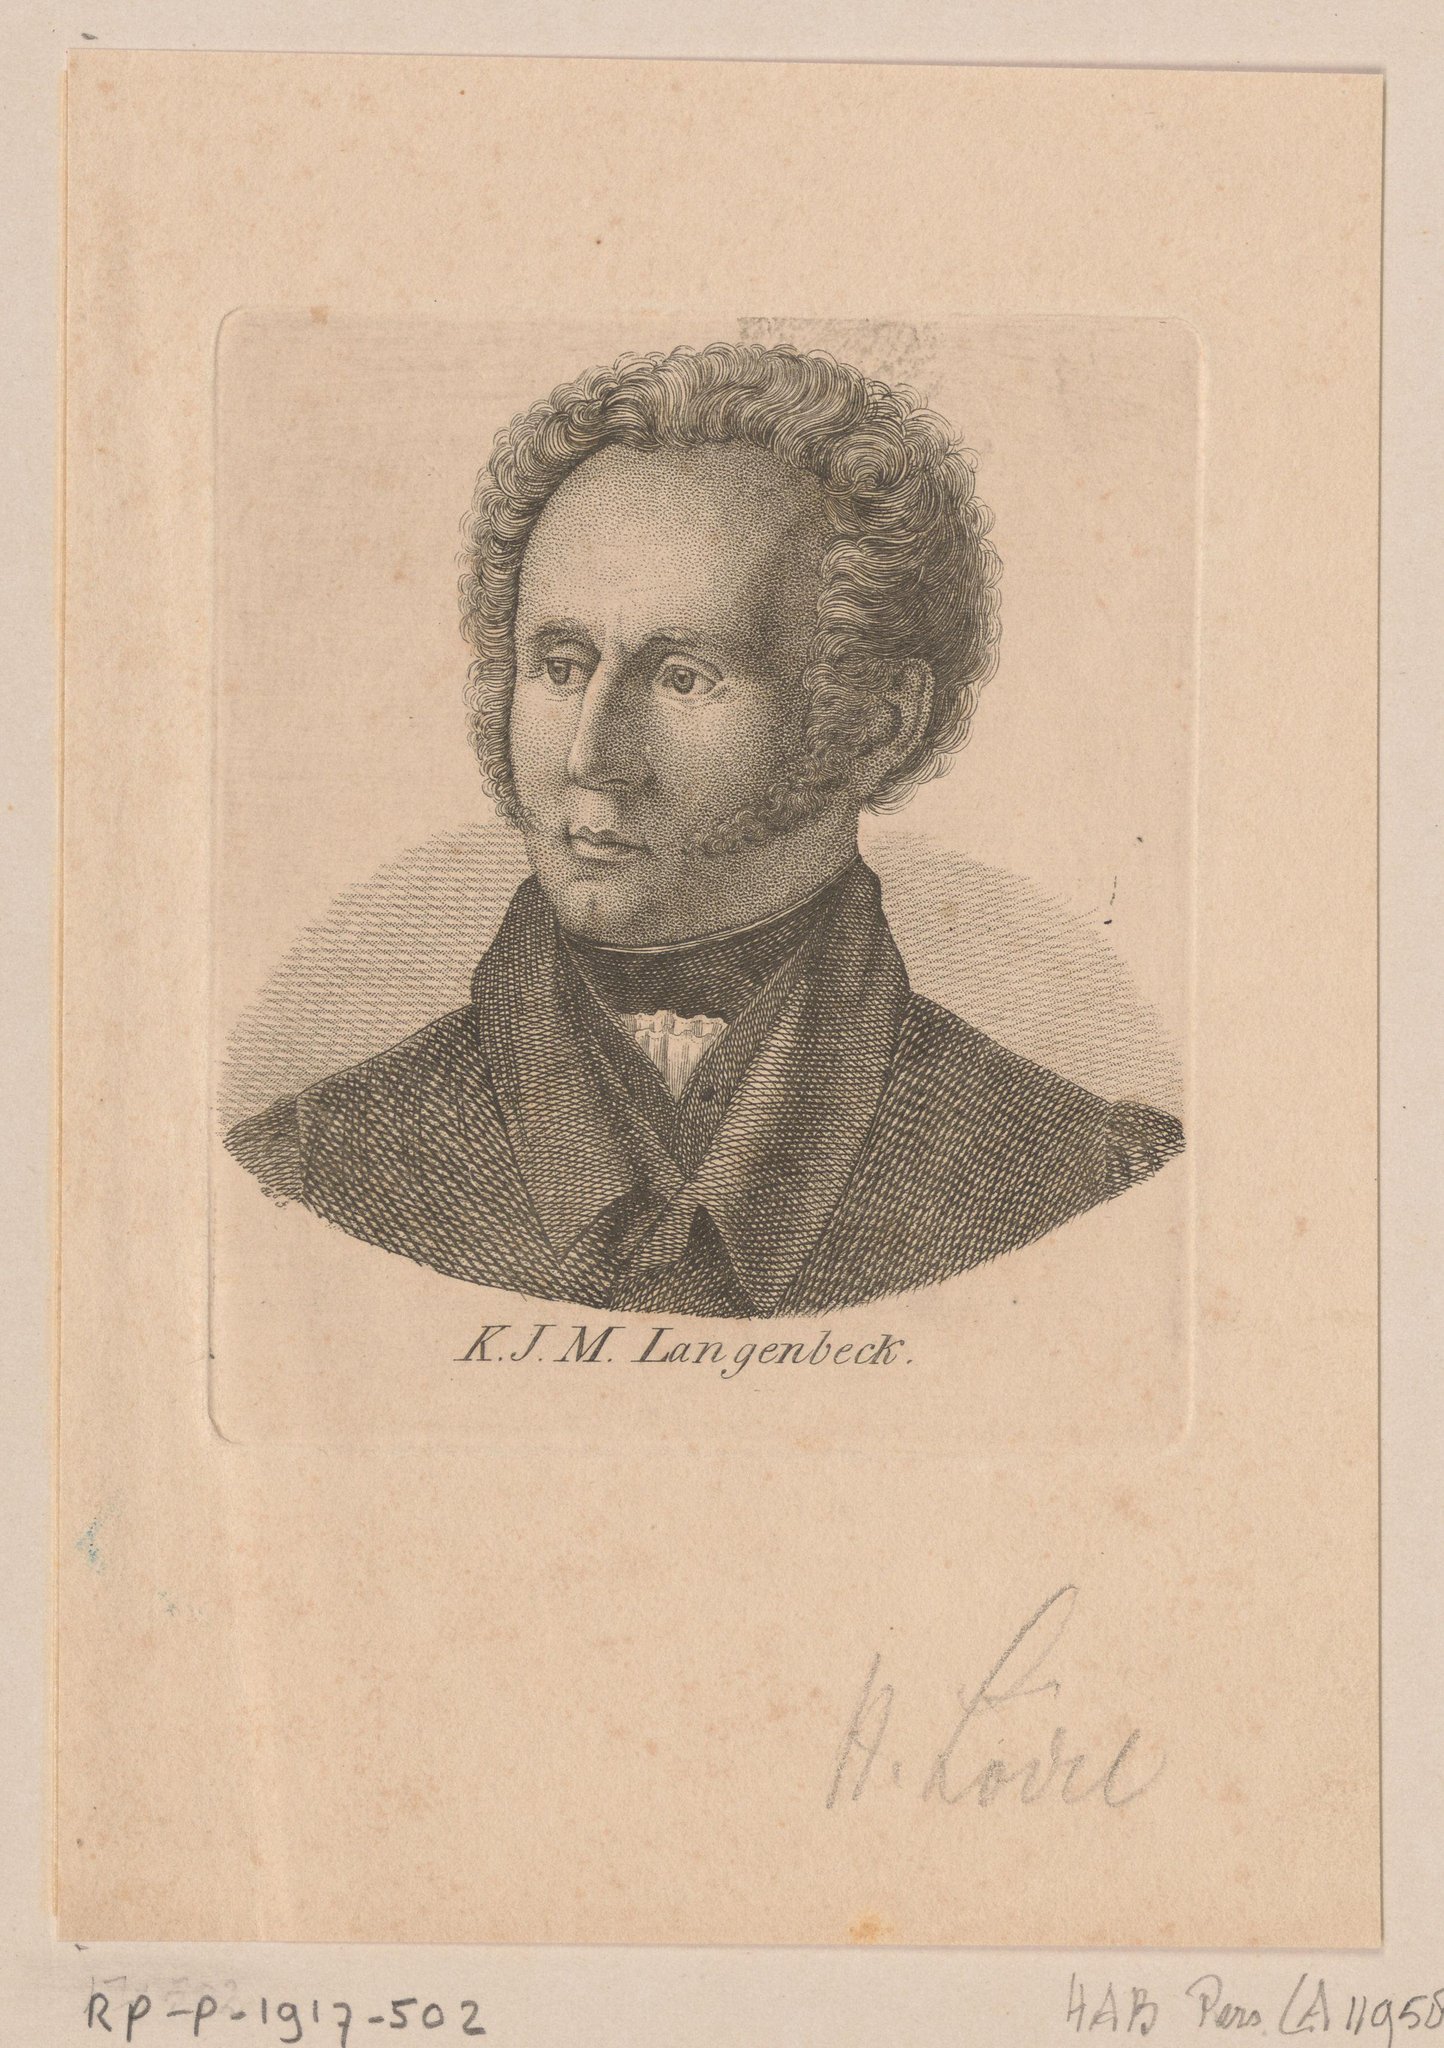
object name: print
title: Portret van Konrad Johann Martin Langenbeck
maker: heinrich lödel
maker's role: print maker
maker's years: 1798-1861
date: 1808-1861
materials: paper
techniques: etching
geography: germany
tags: barber; surgeon (+ portrait of scholar, scientist), historical persons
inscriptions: collector's mark: Lugt 2228